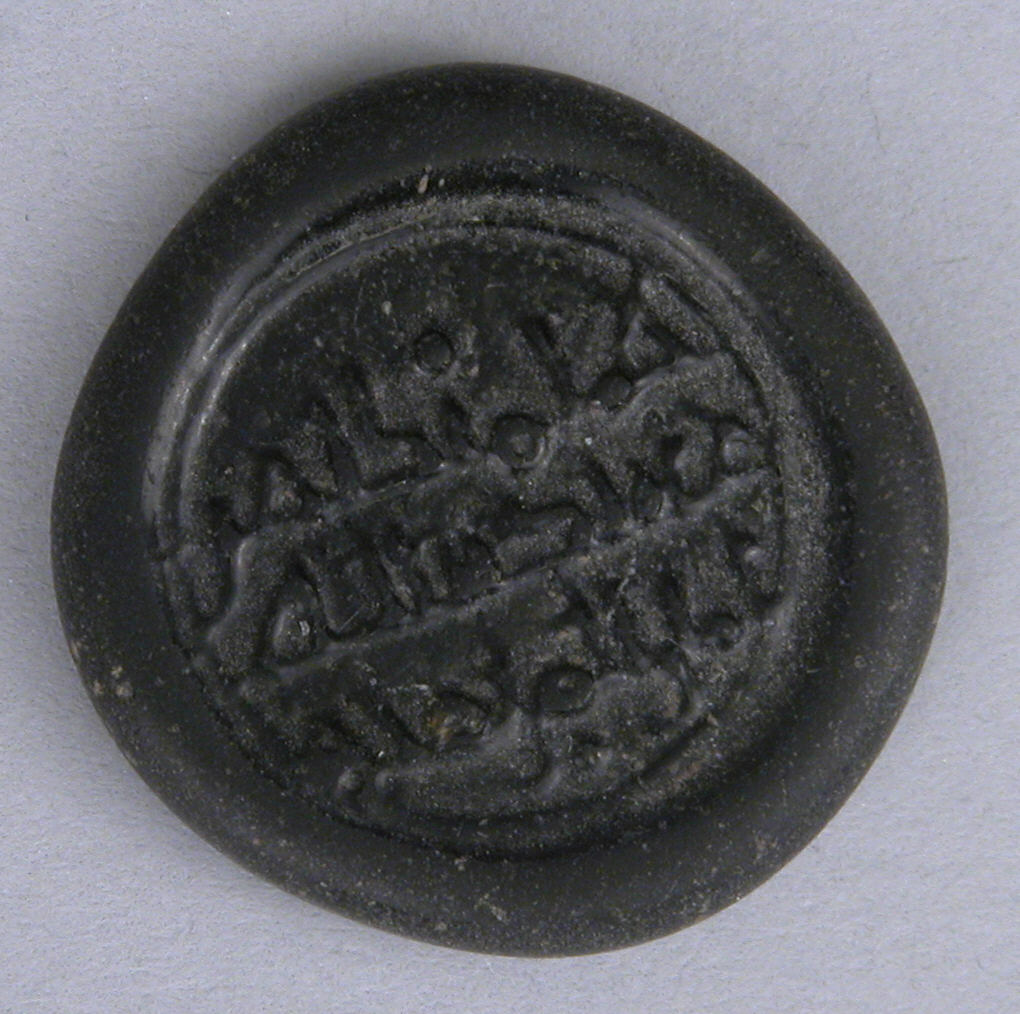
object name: coin weight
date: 1001-1100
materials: glass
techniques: pressed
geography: egypt